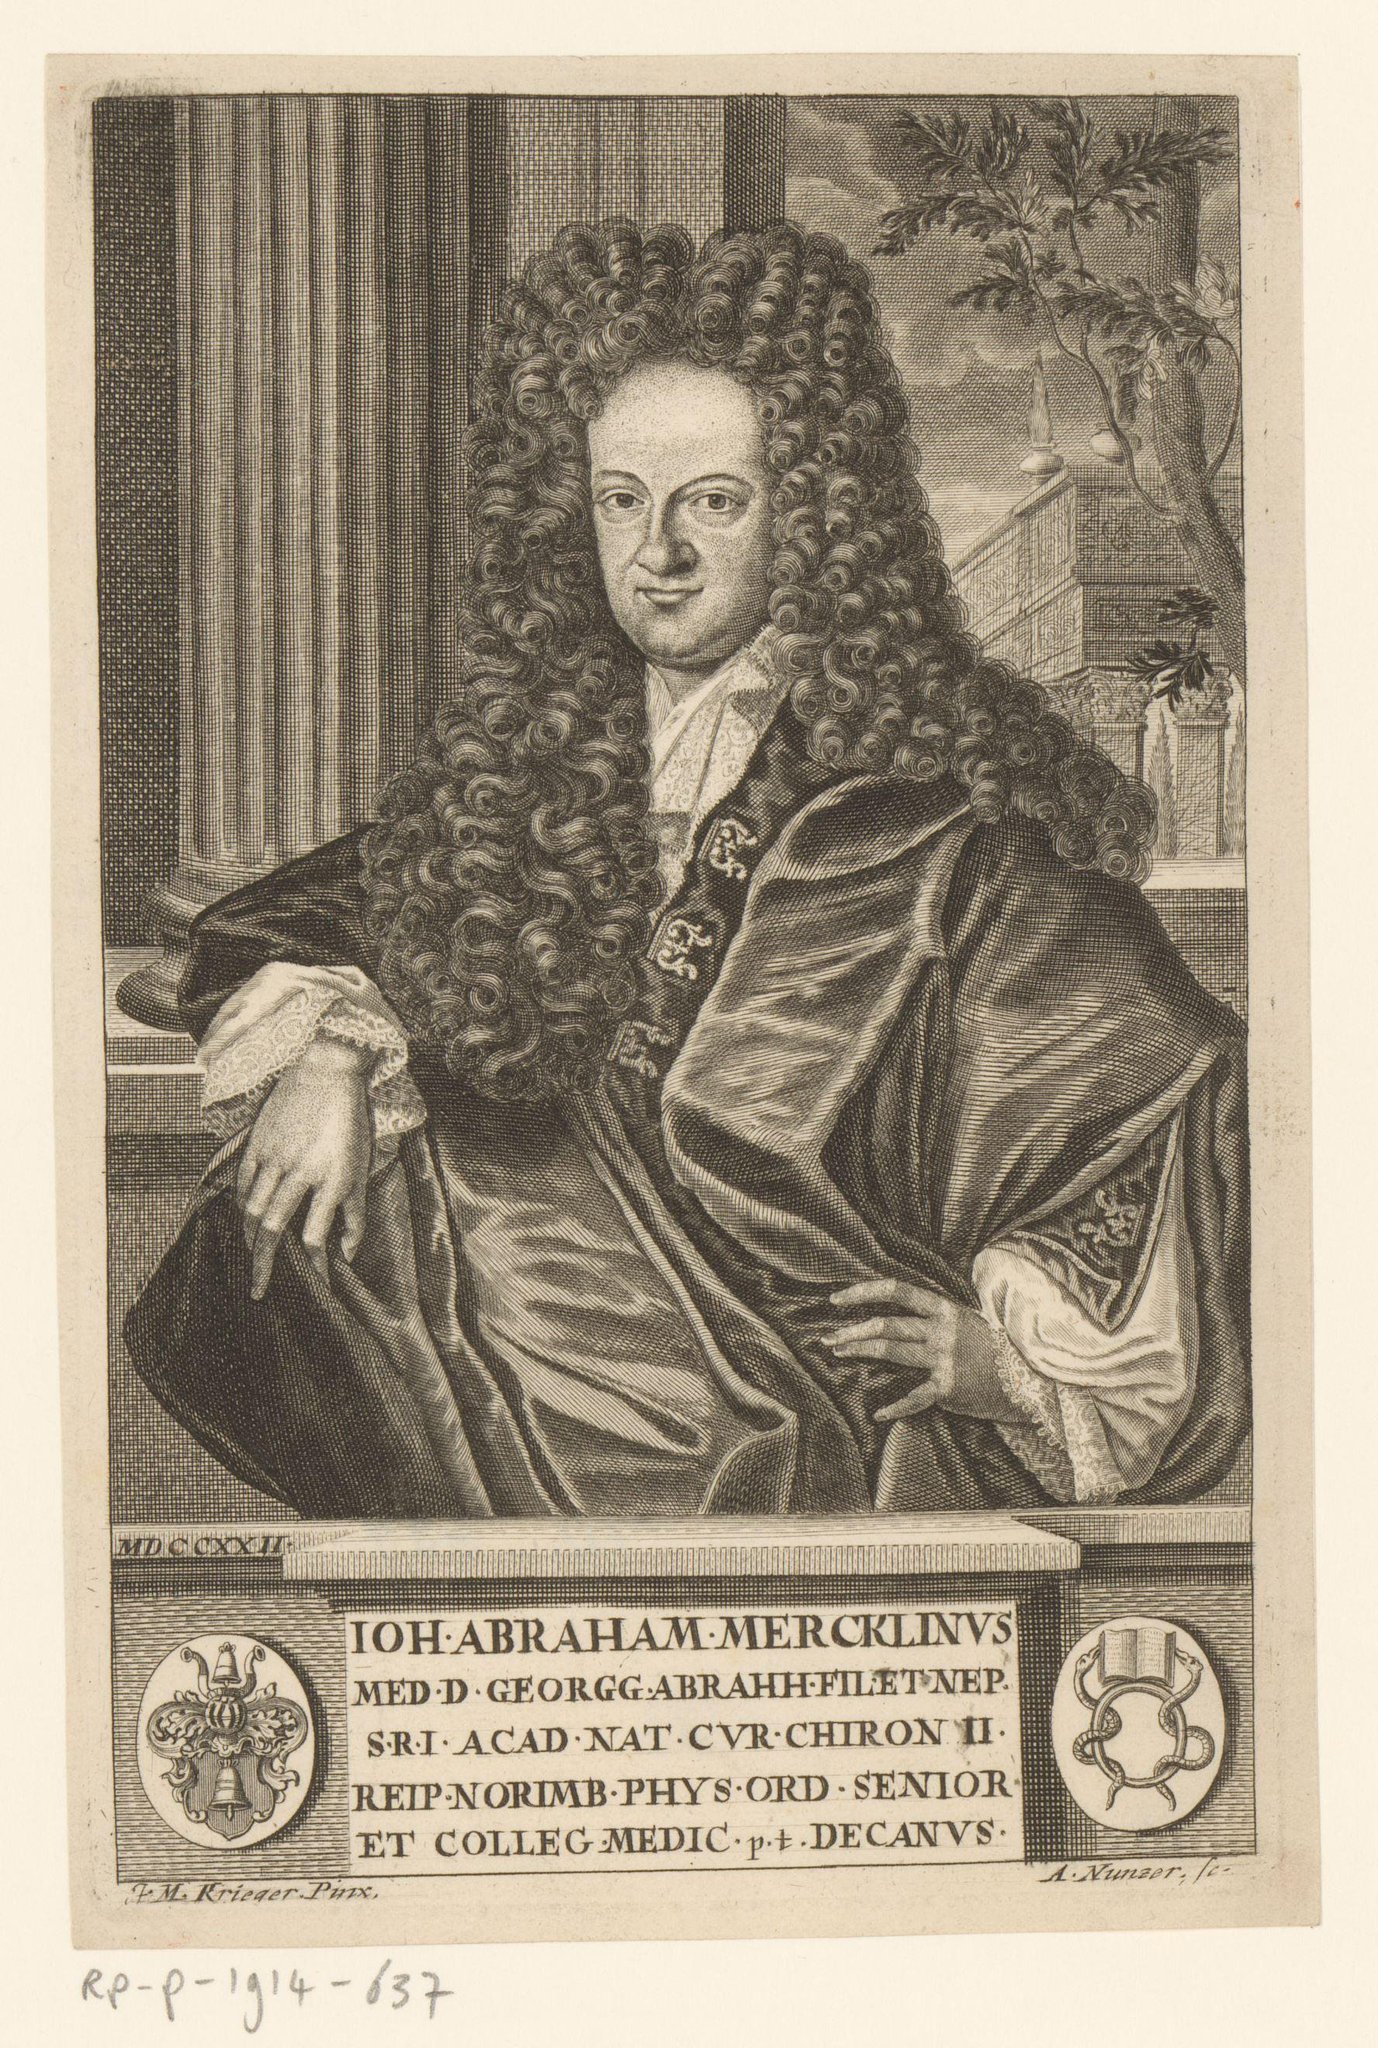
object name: print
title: Portret van Johann Abraham Mercklin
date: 1722-1749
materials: paper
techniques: engraving, etching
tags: historical persons, armorial bearing, heraldry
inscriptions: collector's mark: Lugt 2228